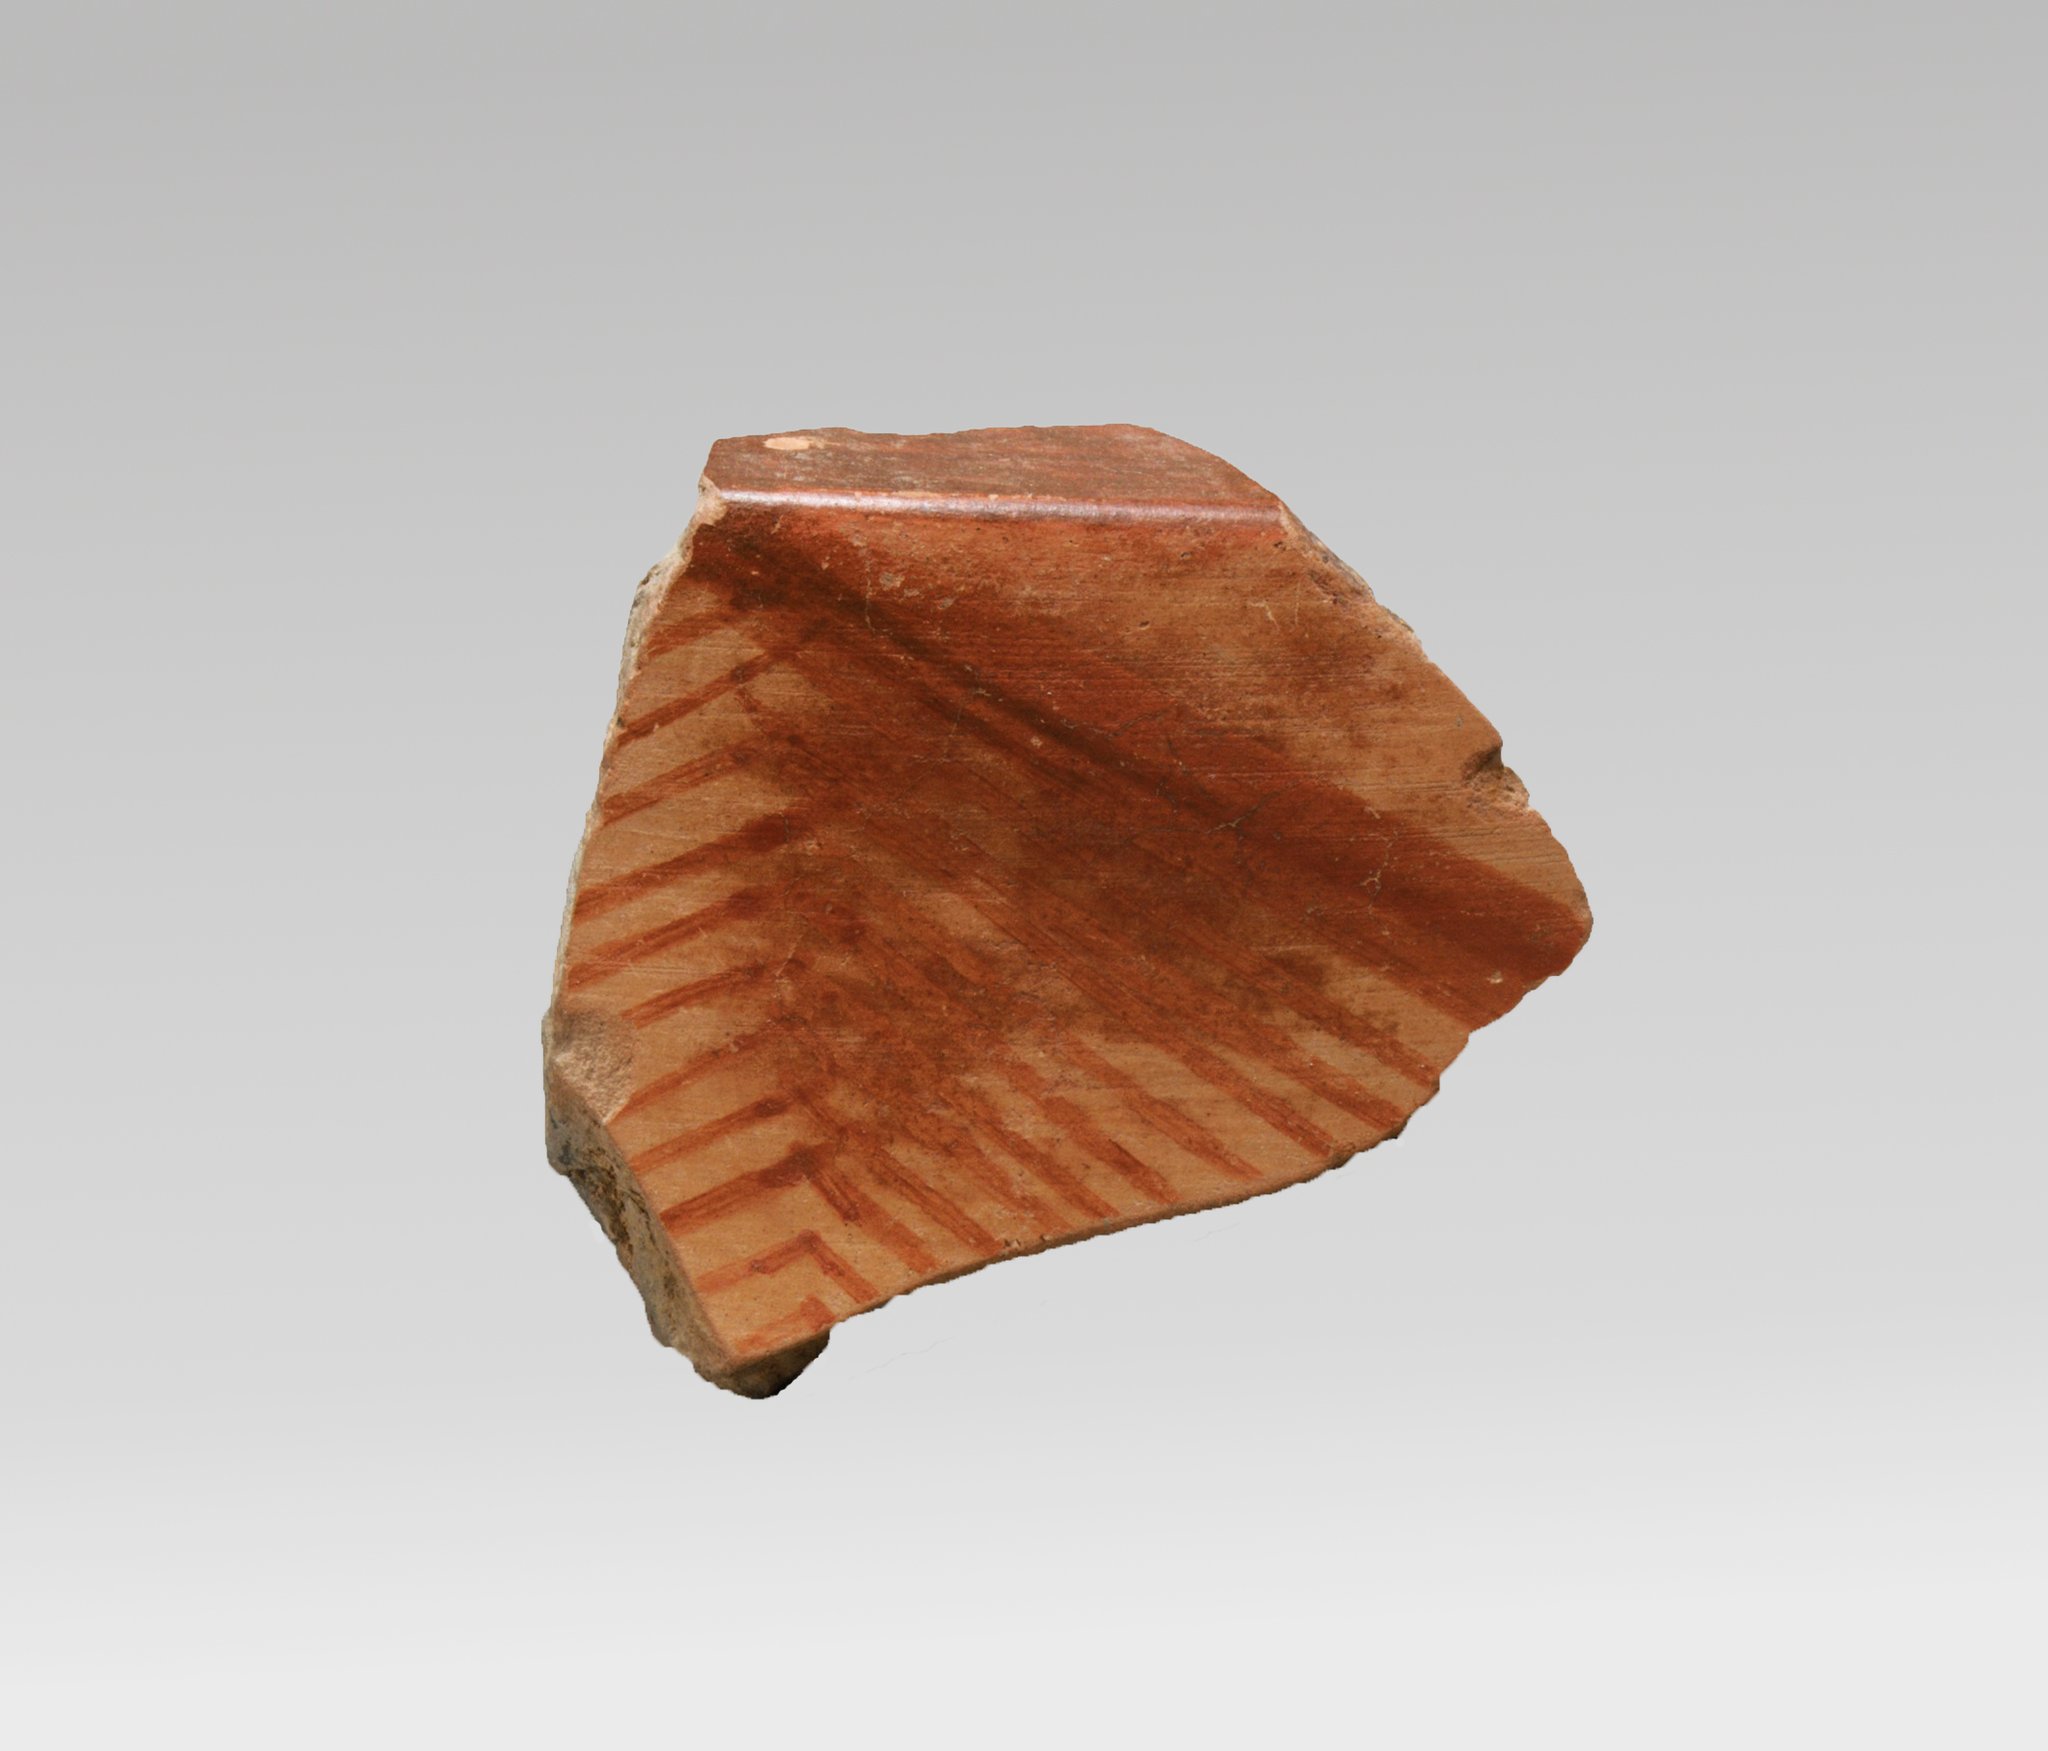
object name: vase fragment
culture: neolithic, hagiorgetika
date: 4000-3000 BCE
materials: terracotta